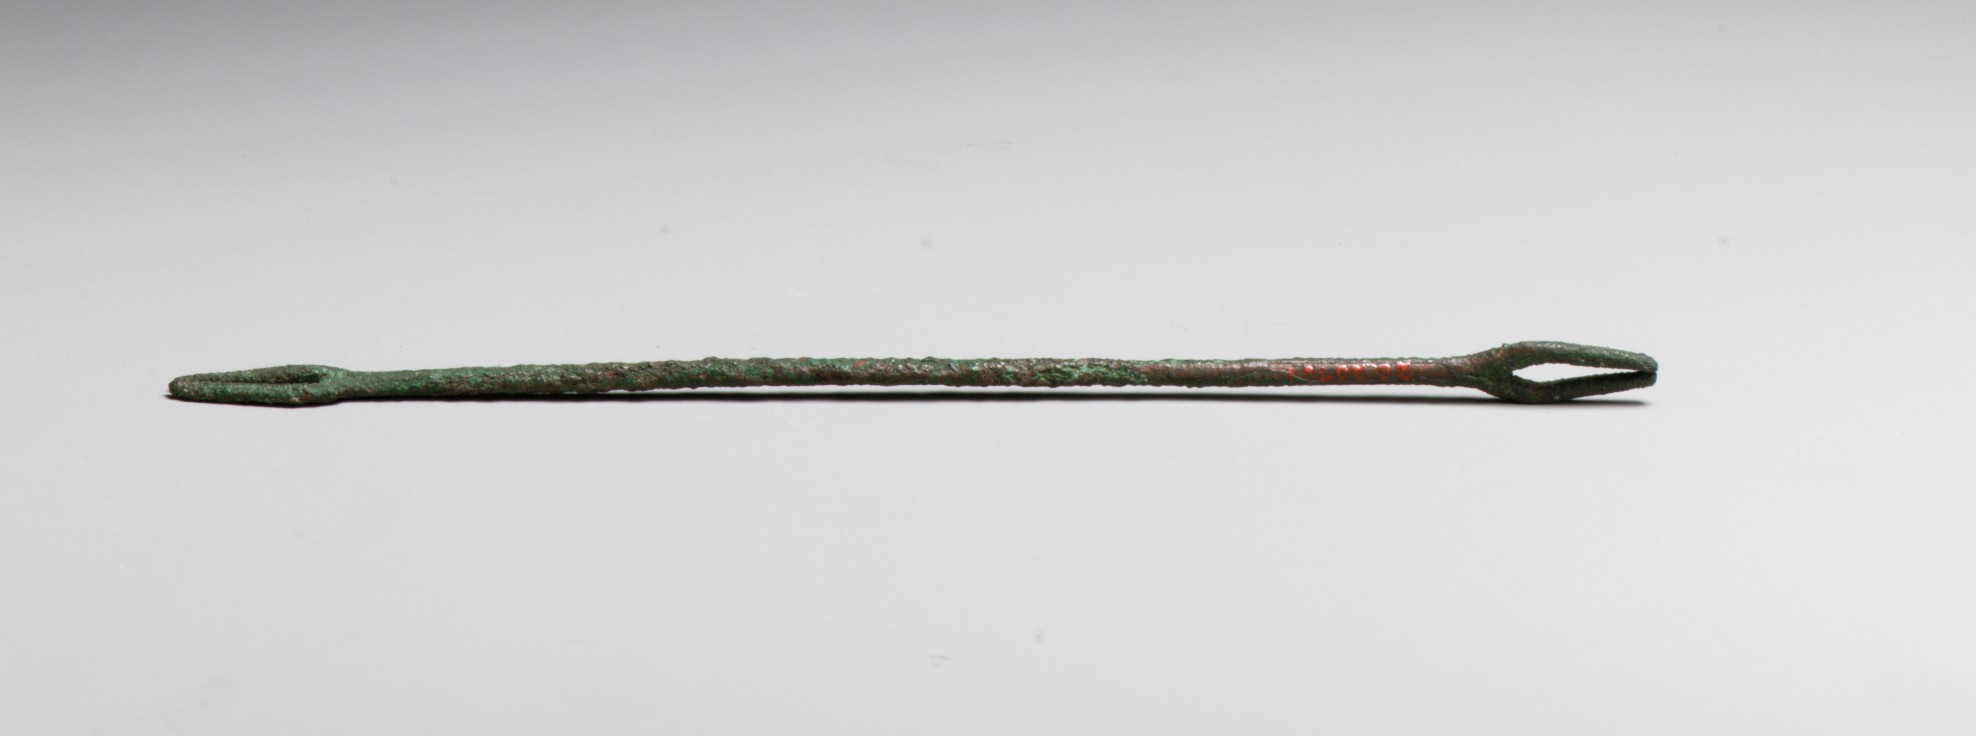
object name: needle, netting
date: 7000 BCE-330 CE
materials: bronze